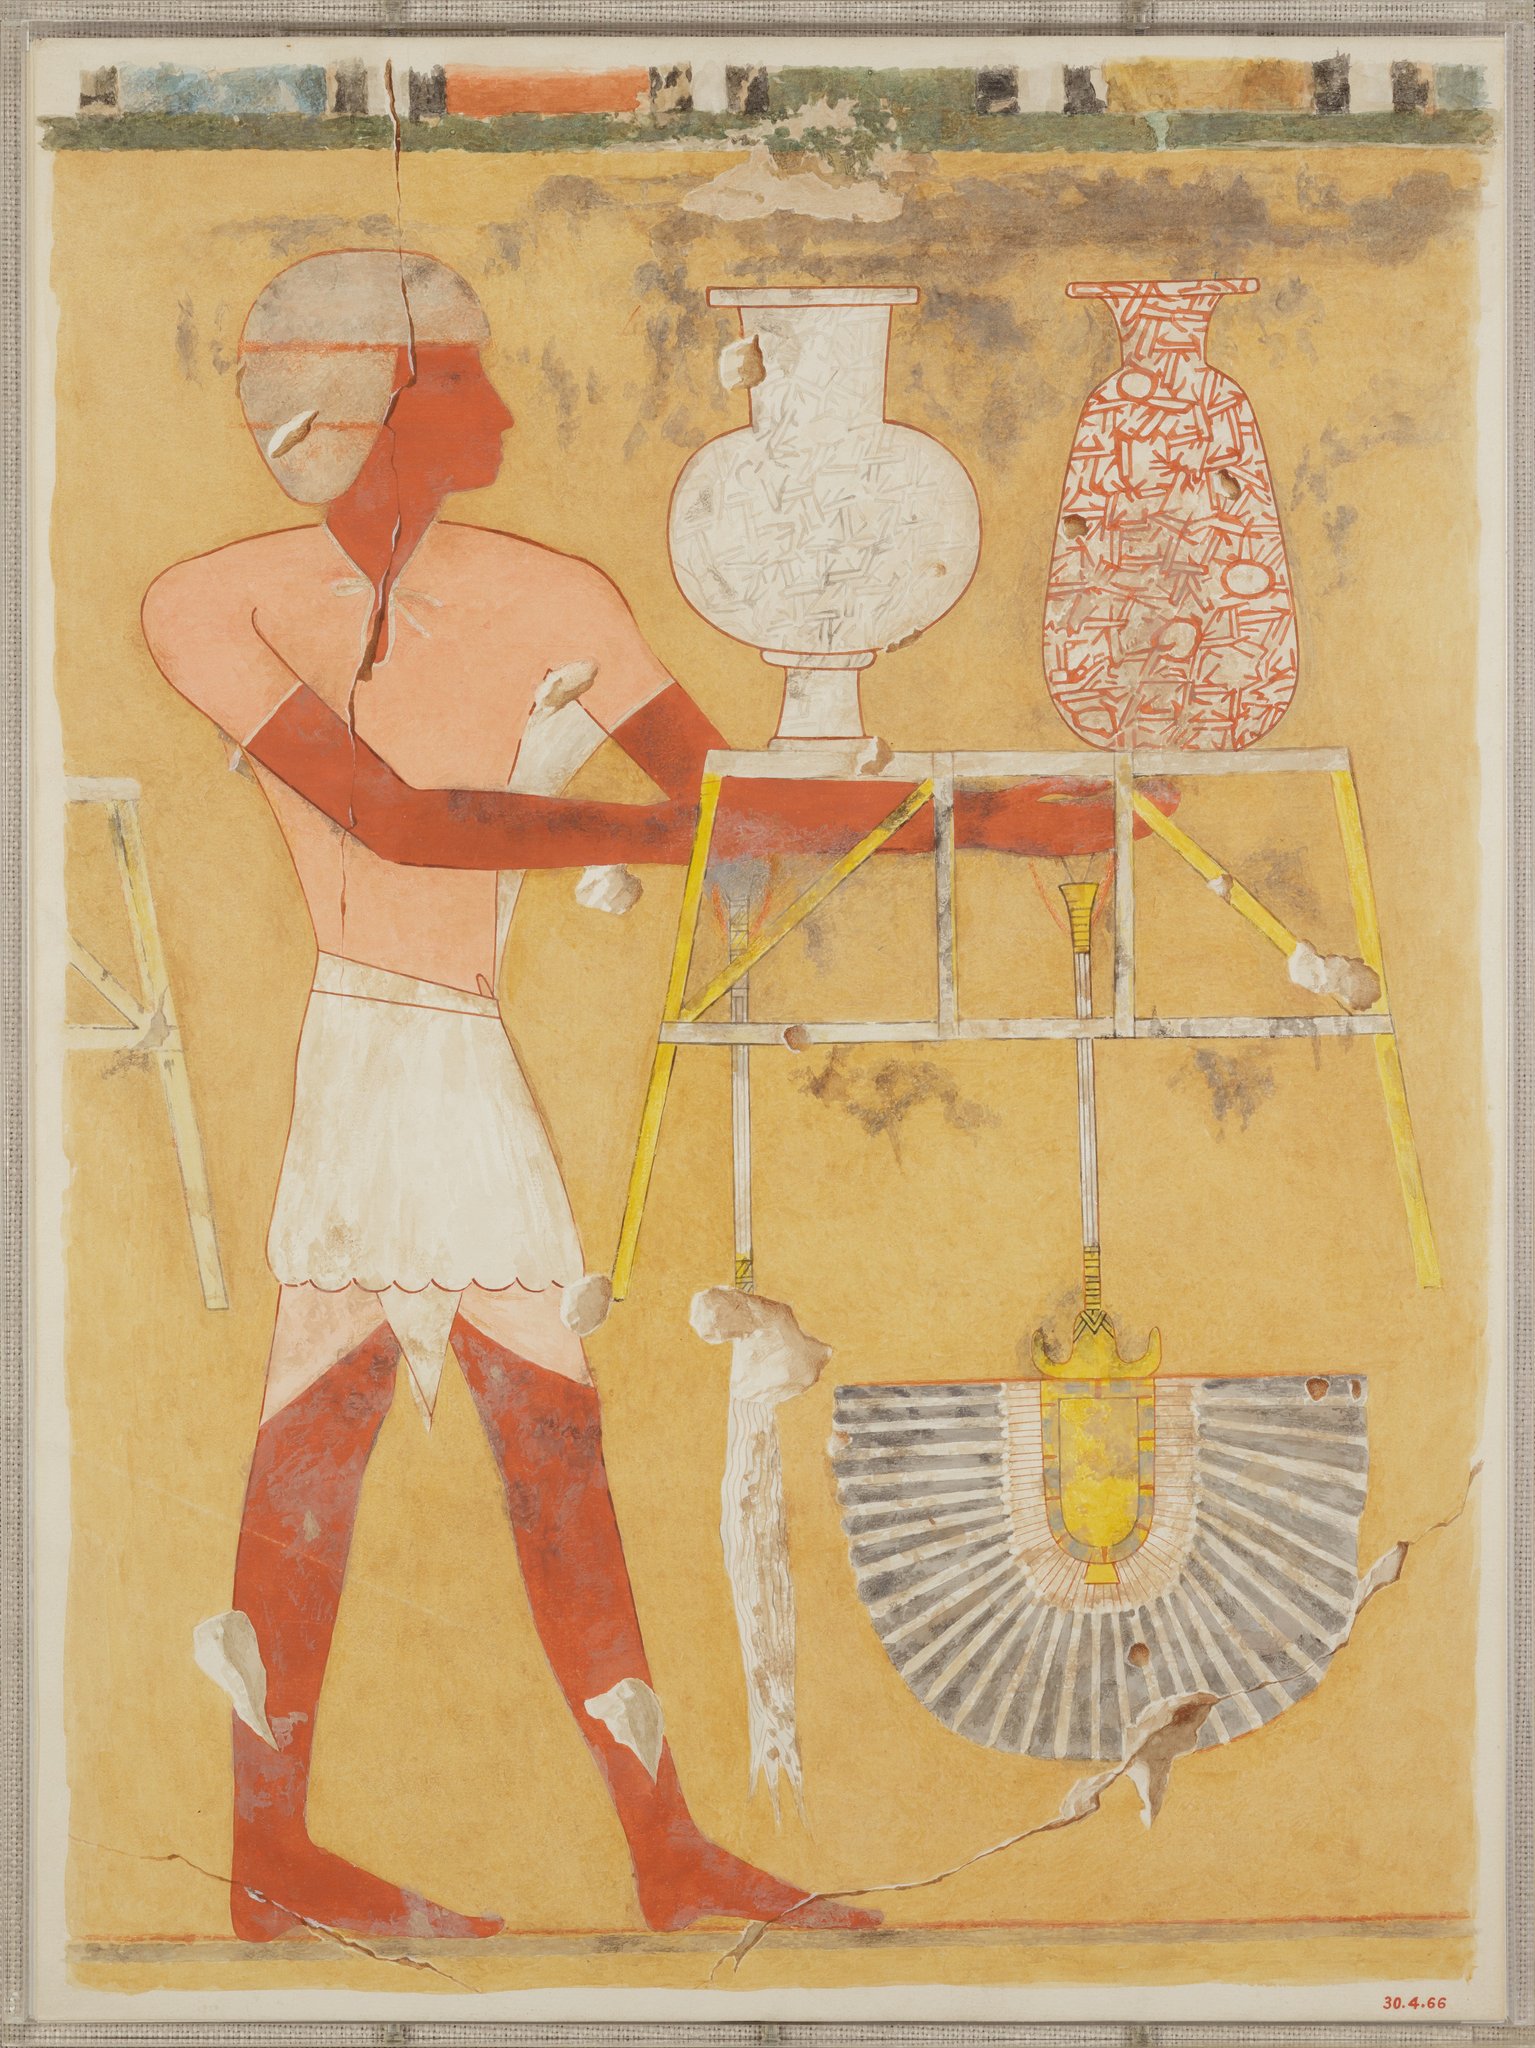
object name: facsimile, qenamun tt 93, offering bearer, man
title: Man Bringing New Year's Gifts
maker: hugh r. hopgood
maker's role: artist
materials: paper, paint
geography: egypt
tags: men,drink-and-be-merry